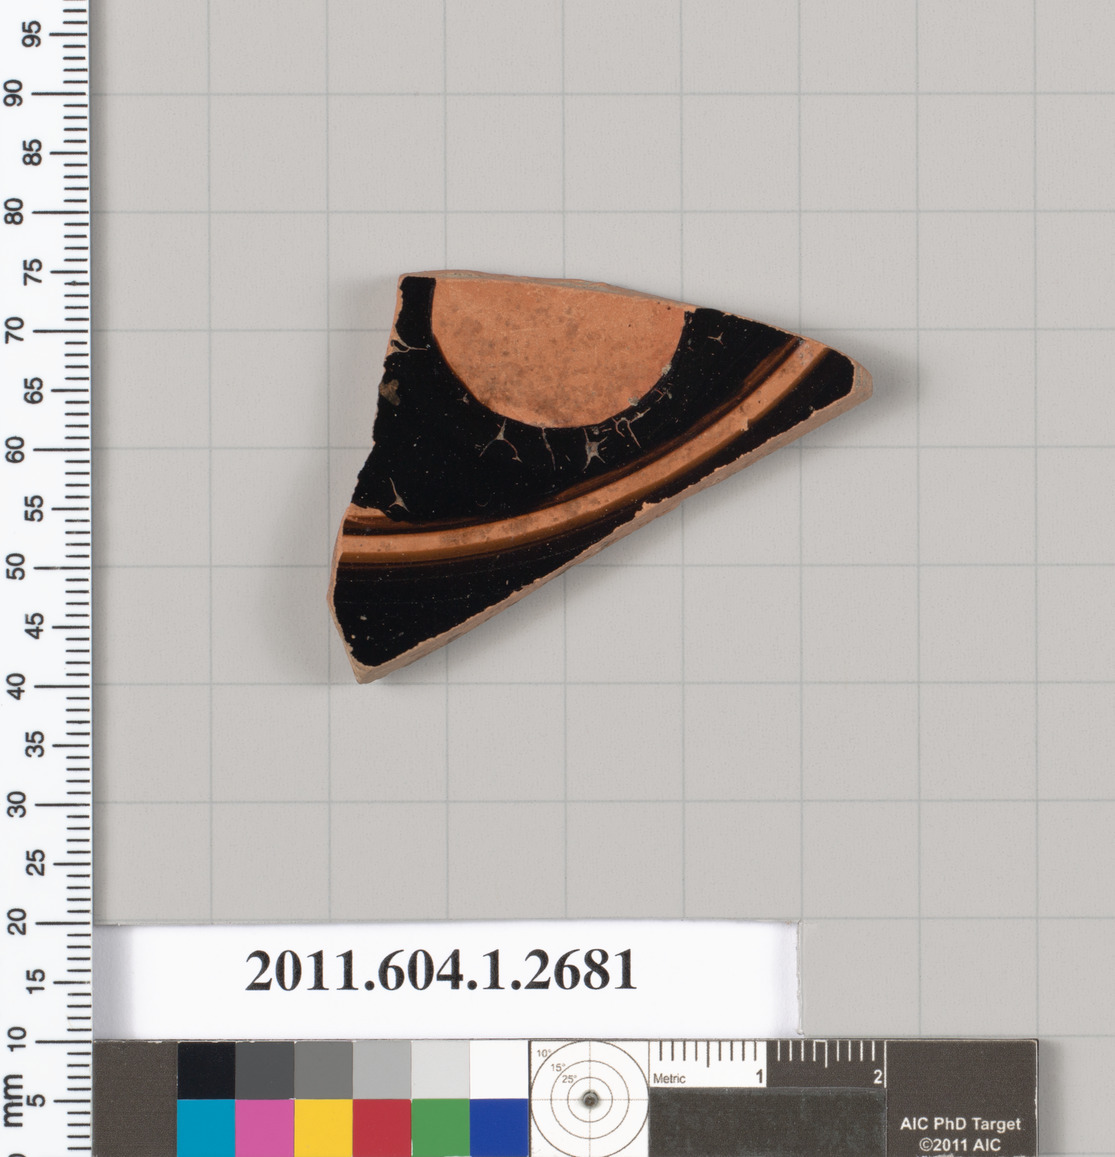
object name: kylix fragment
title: Terracotta fragment of a kylix (drinking cup)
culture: greek, attic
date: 500-490 BCE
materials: terracotta